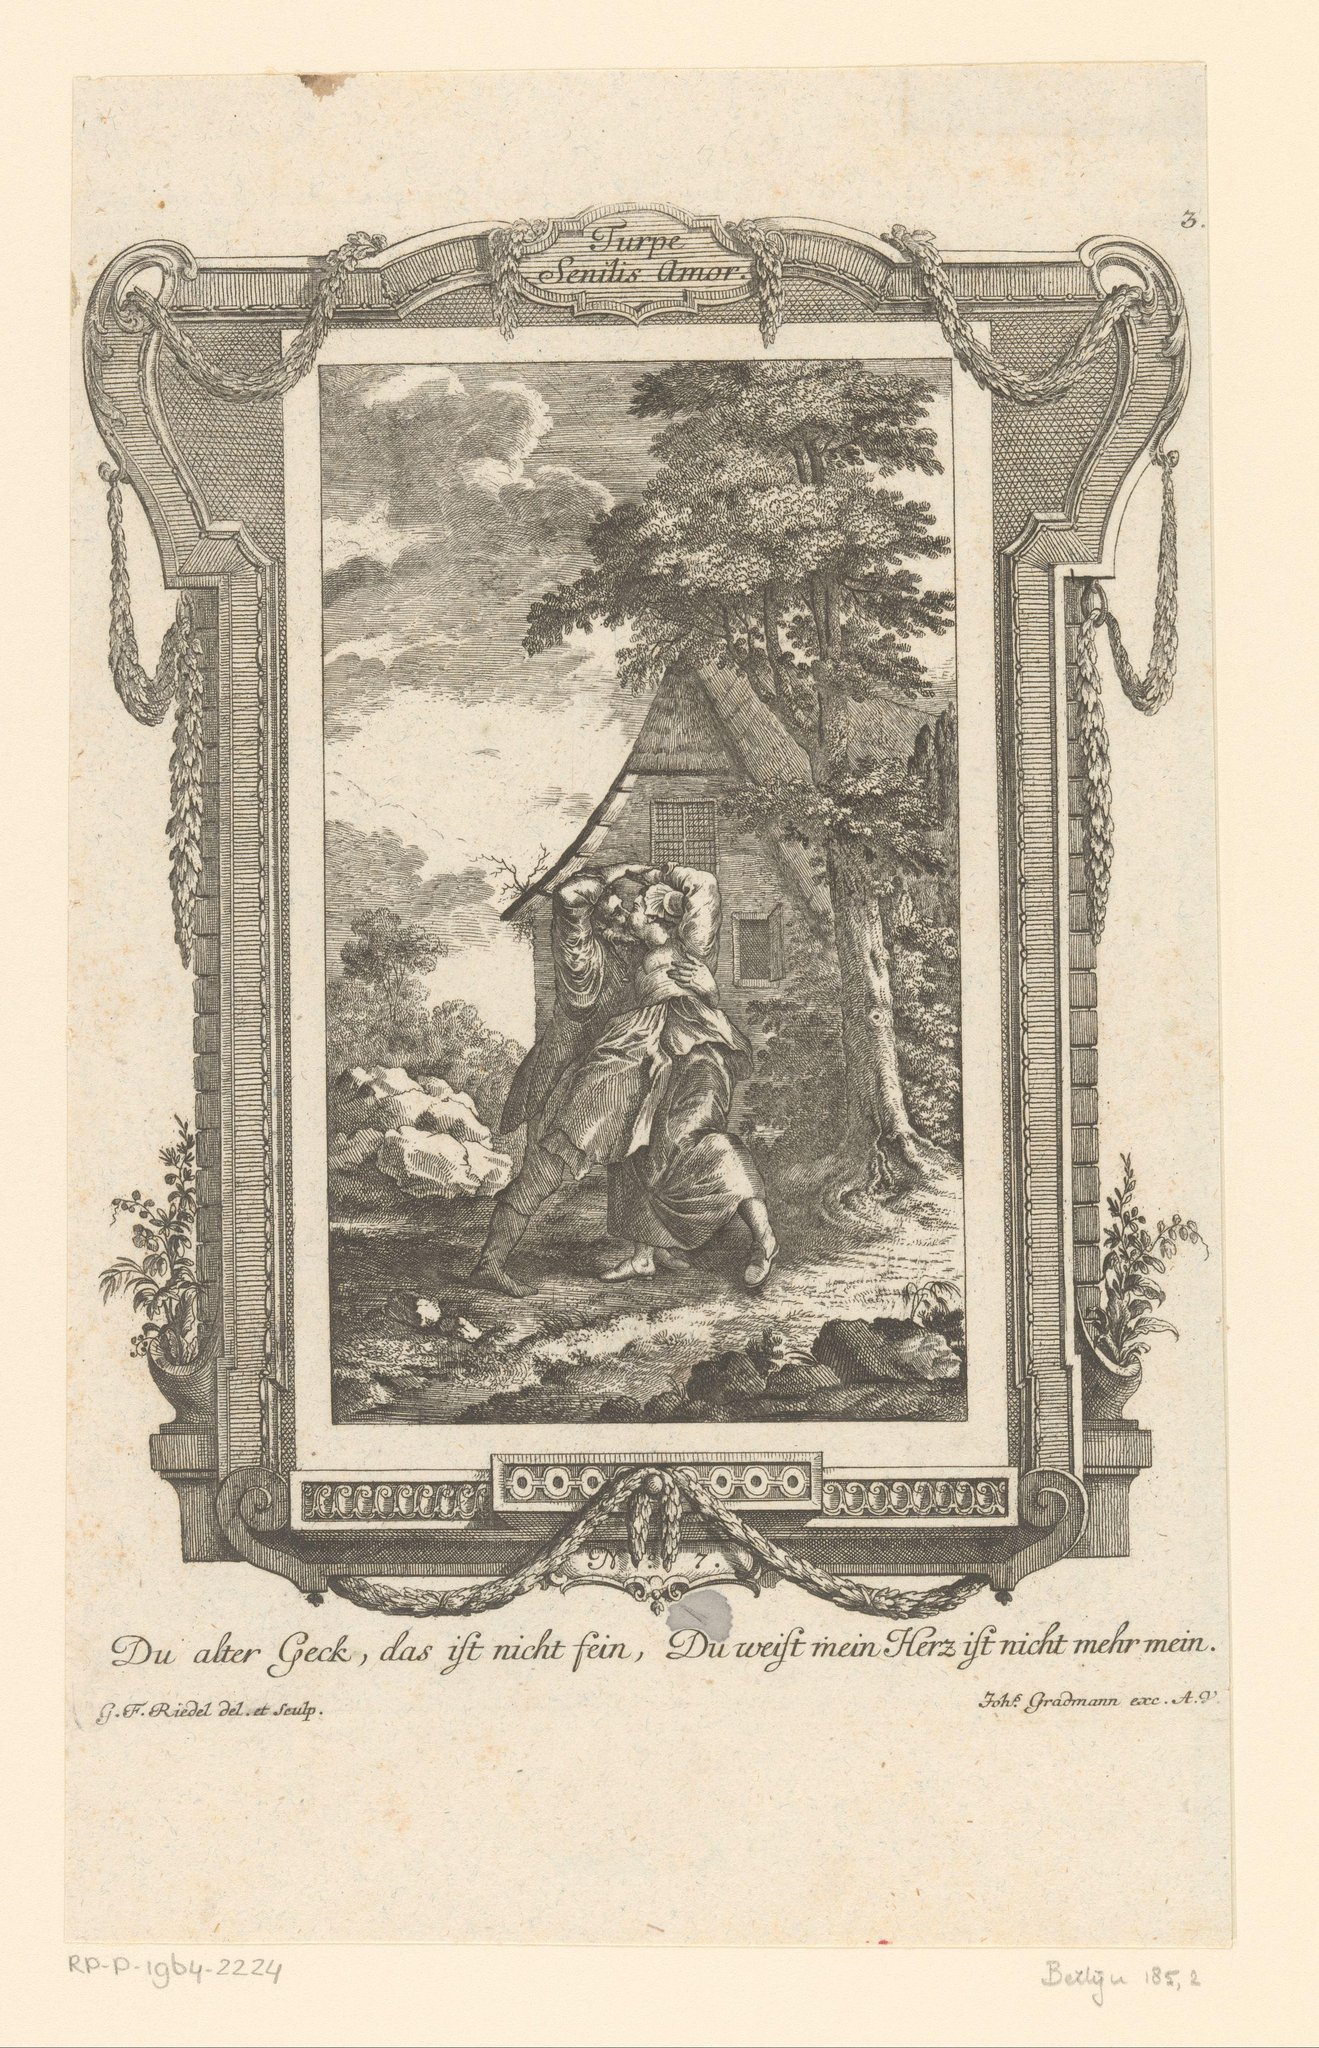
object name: ornament print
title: Pastorale liefdesscènes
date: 1778-1779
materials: paper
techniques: etching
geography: augsburg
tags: (lovers) kissing each other, pastorals, arcadian scenes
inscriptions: collector's mark: Lugt 2228, collector's mark: Lugt 2760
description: Een ouder verliefd stel kust elkaar voor een gebouw in de buitenlucht. Rondom de voorstelling een omlijsting met guirlandes. In de ondermarge een Duitse tekst. Uitgeversnummer 7.